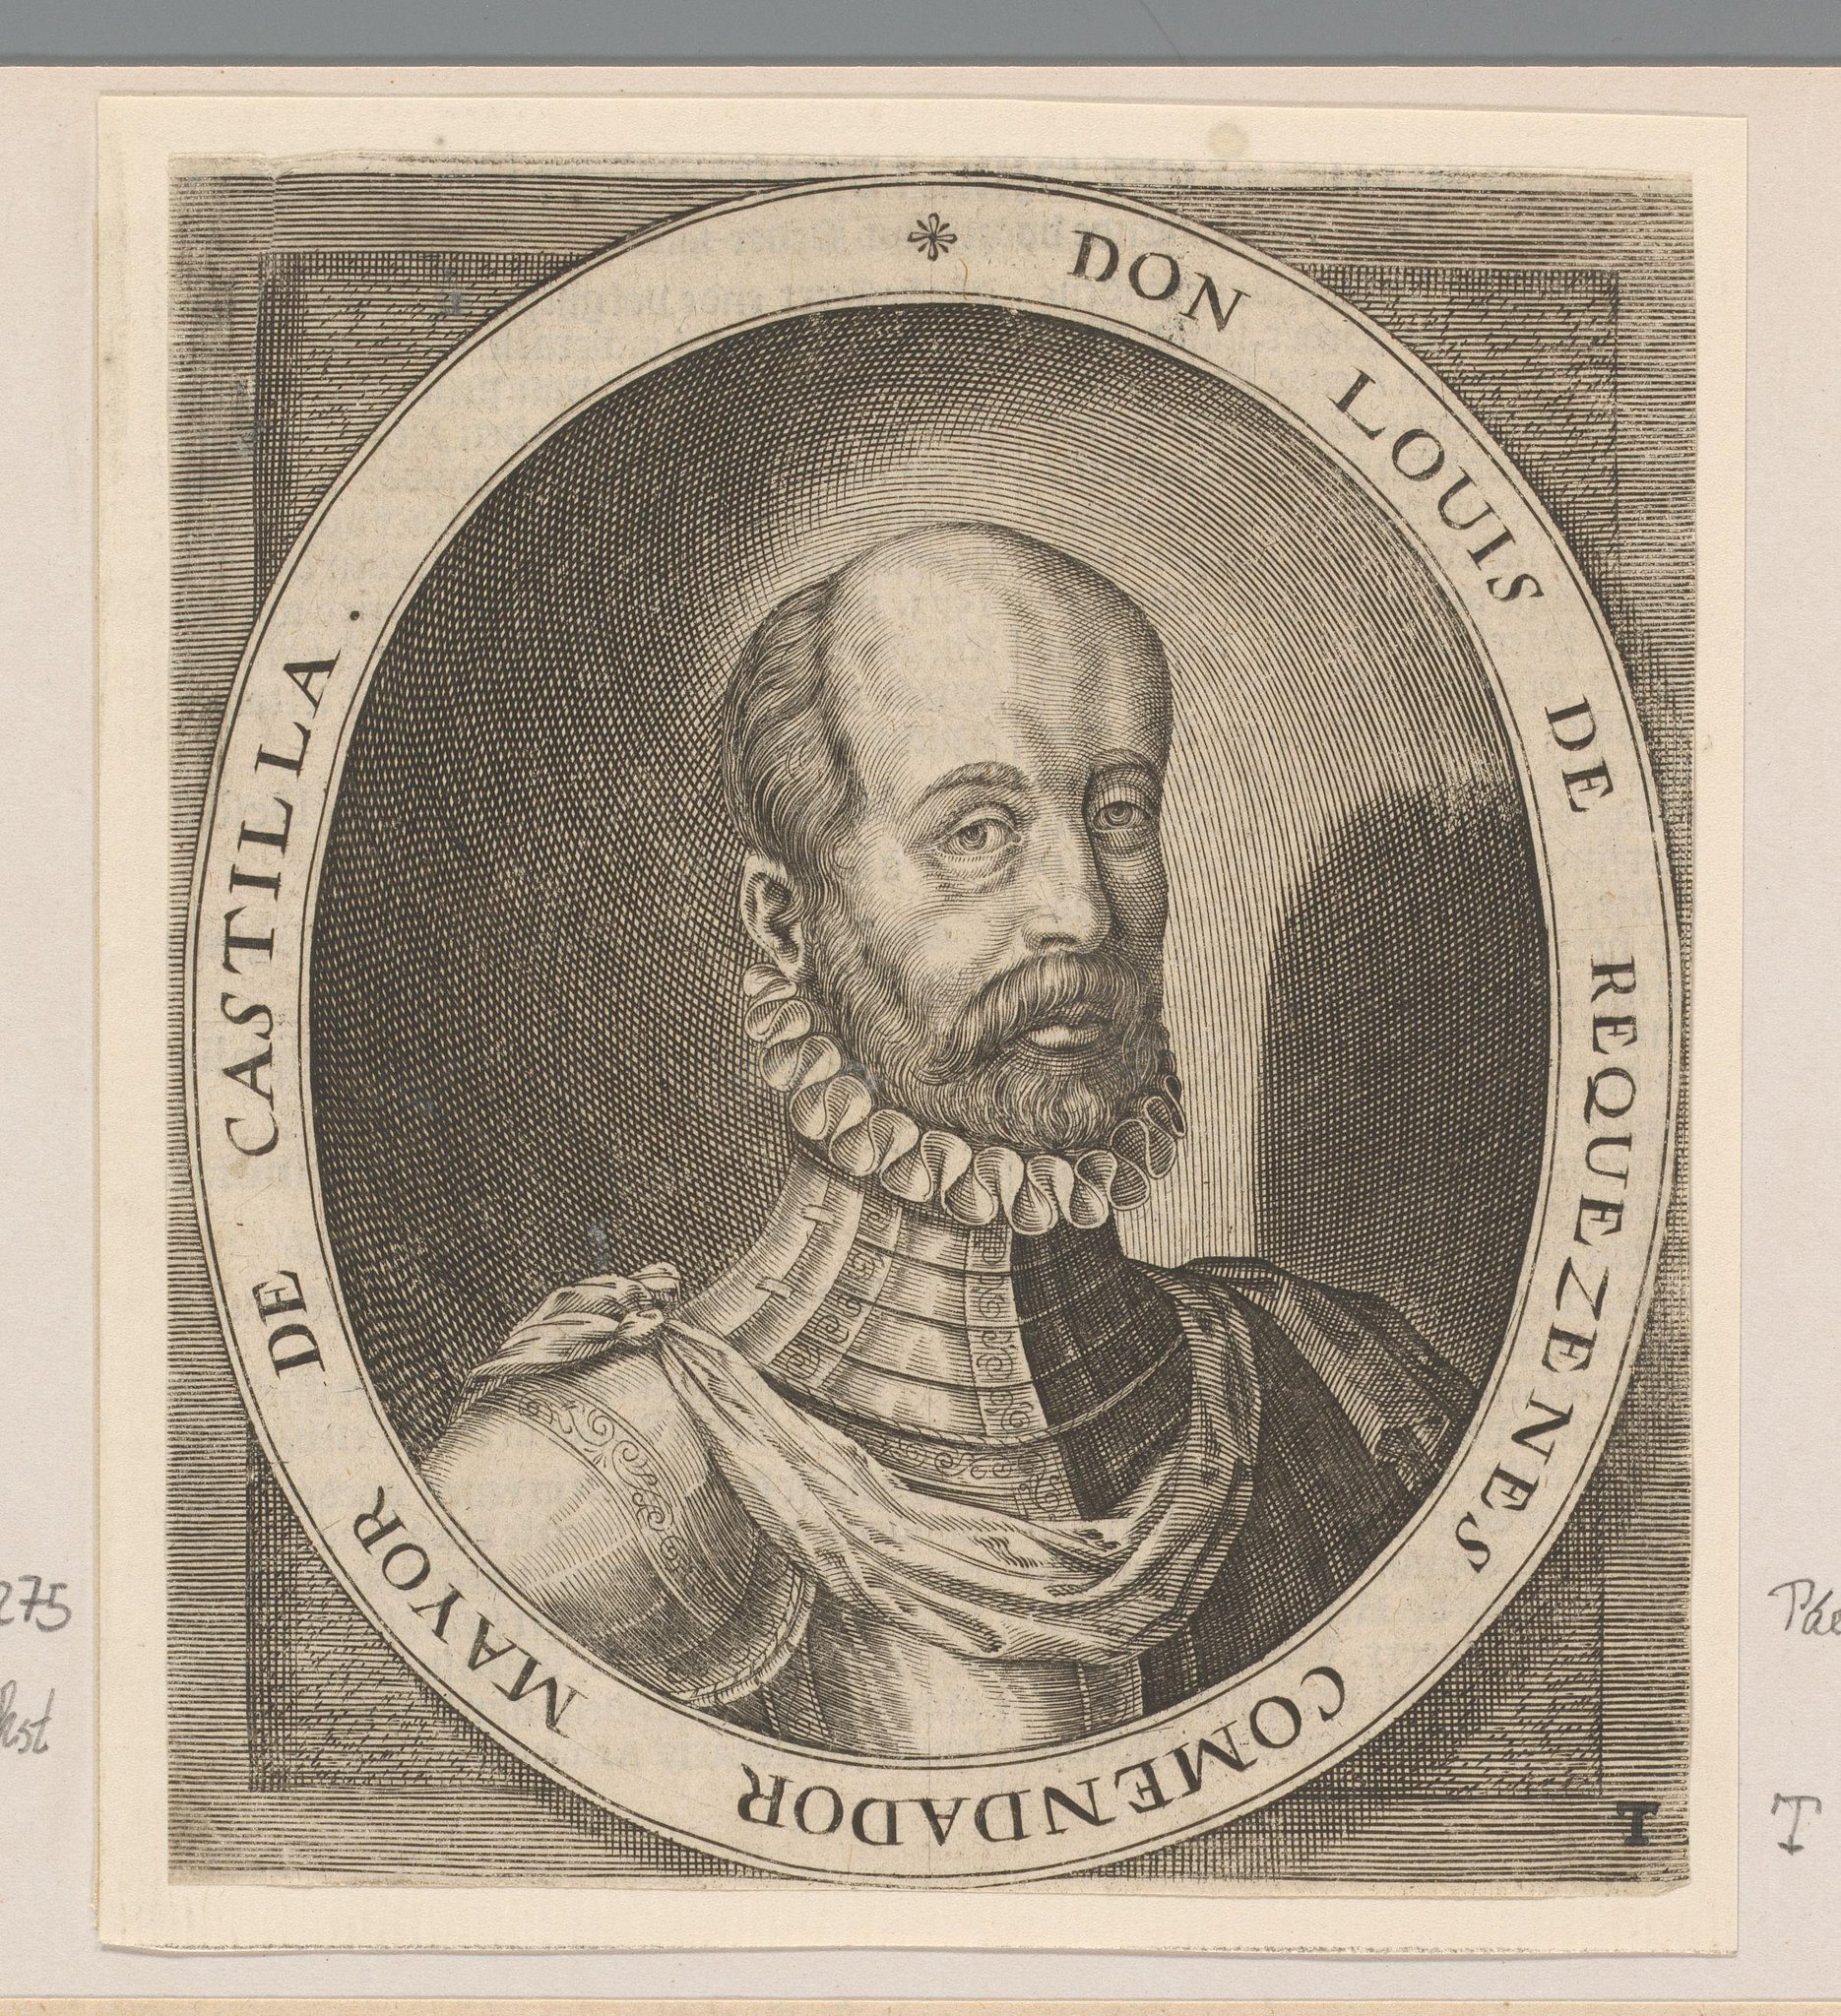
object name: book illustration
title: Portret van Luis de Zúñiga y Requesens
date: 1616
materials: paper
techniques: engraving, letterpress printing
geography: amsterdam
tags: brussels, mayor, luis de zúñiga y requesens, historical persons, governor, etc. of province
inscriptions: stamp: ‘T’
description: Prent uit: Baudaert, Willem. Afbeeldinghe, ende beschrijvinghe van alle de veld-slagen, belegeringen, (...). Amsterdam: Michiel Colijn, 1616.